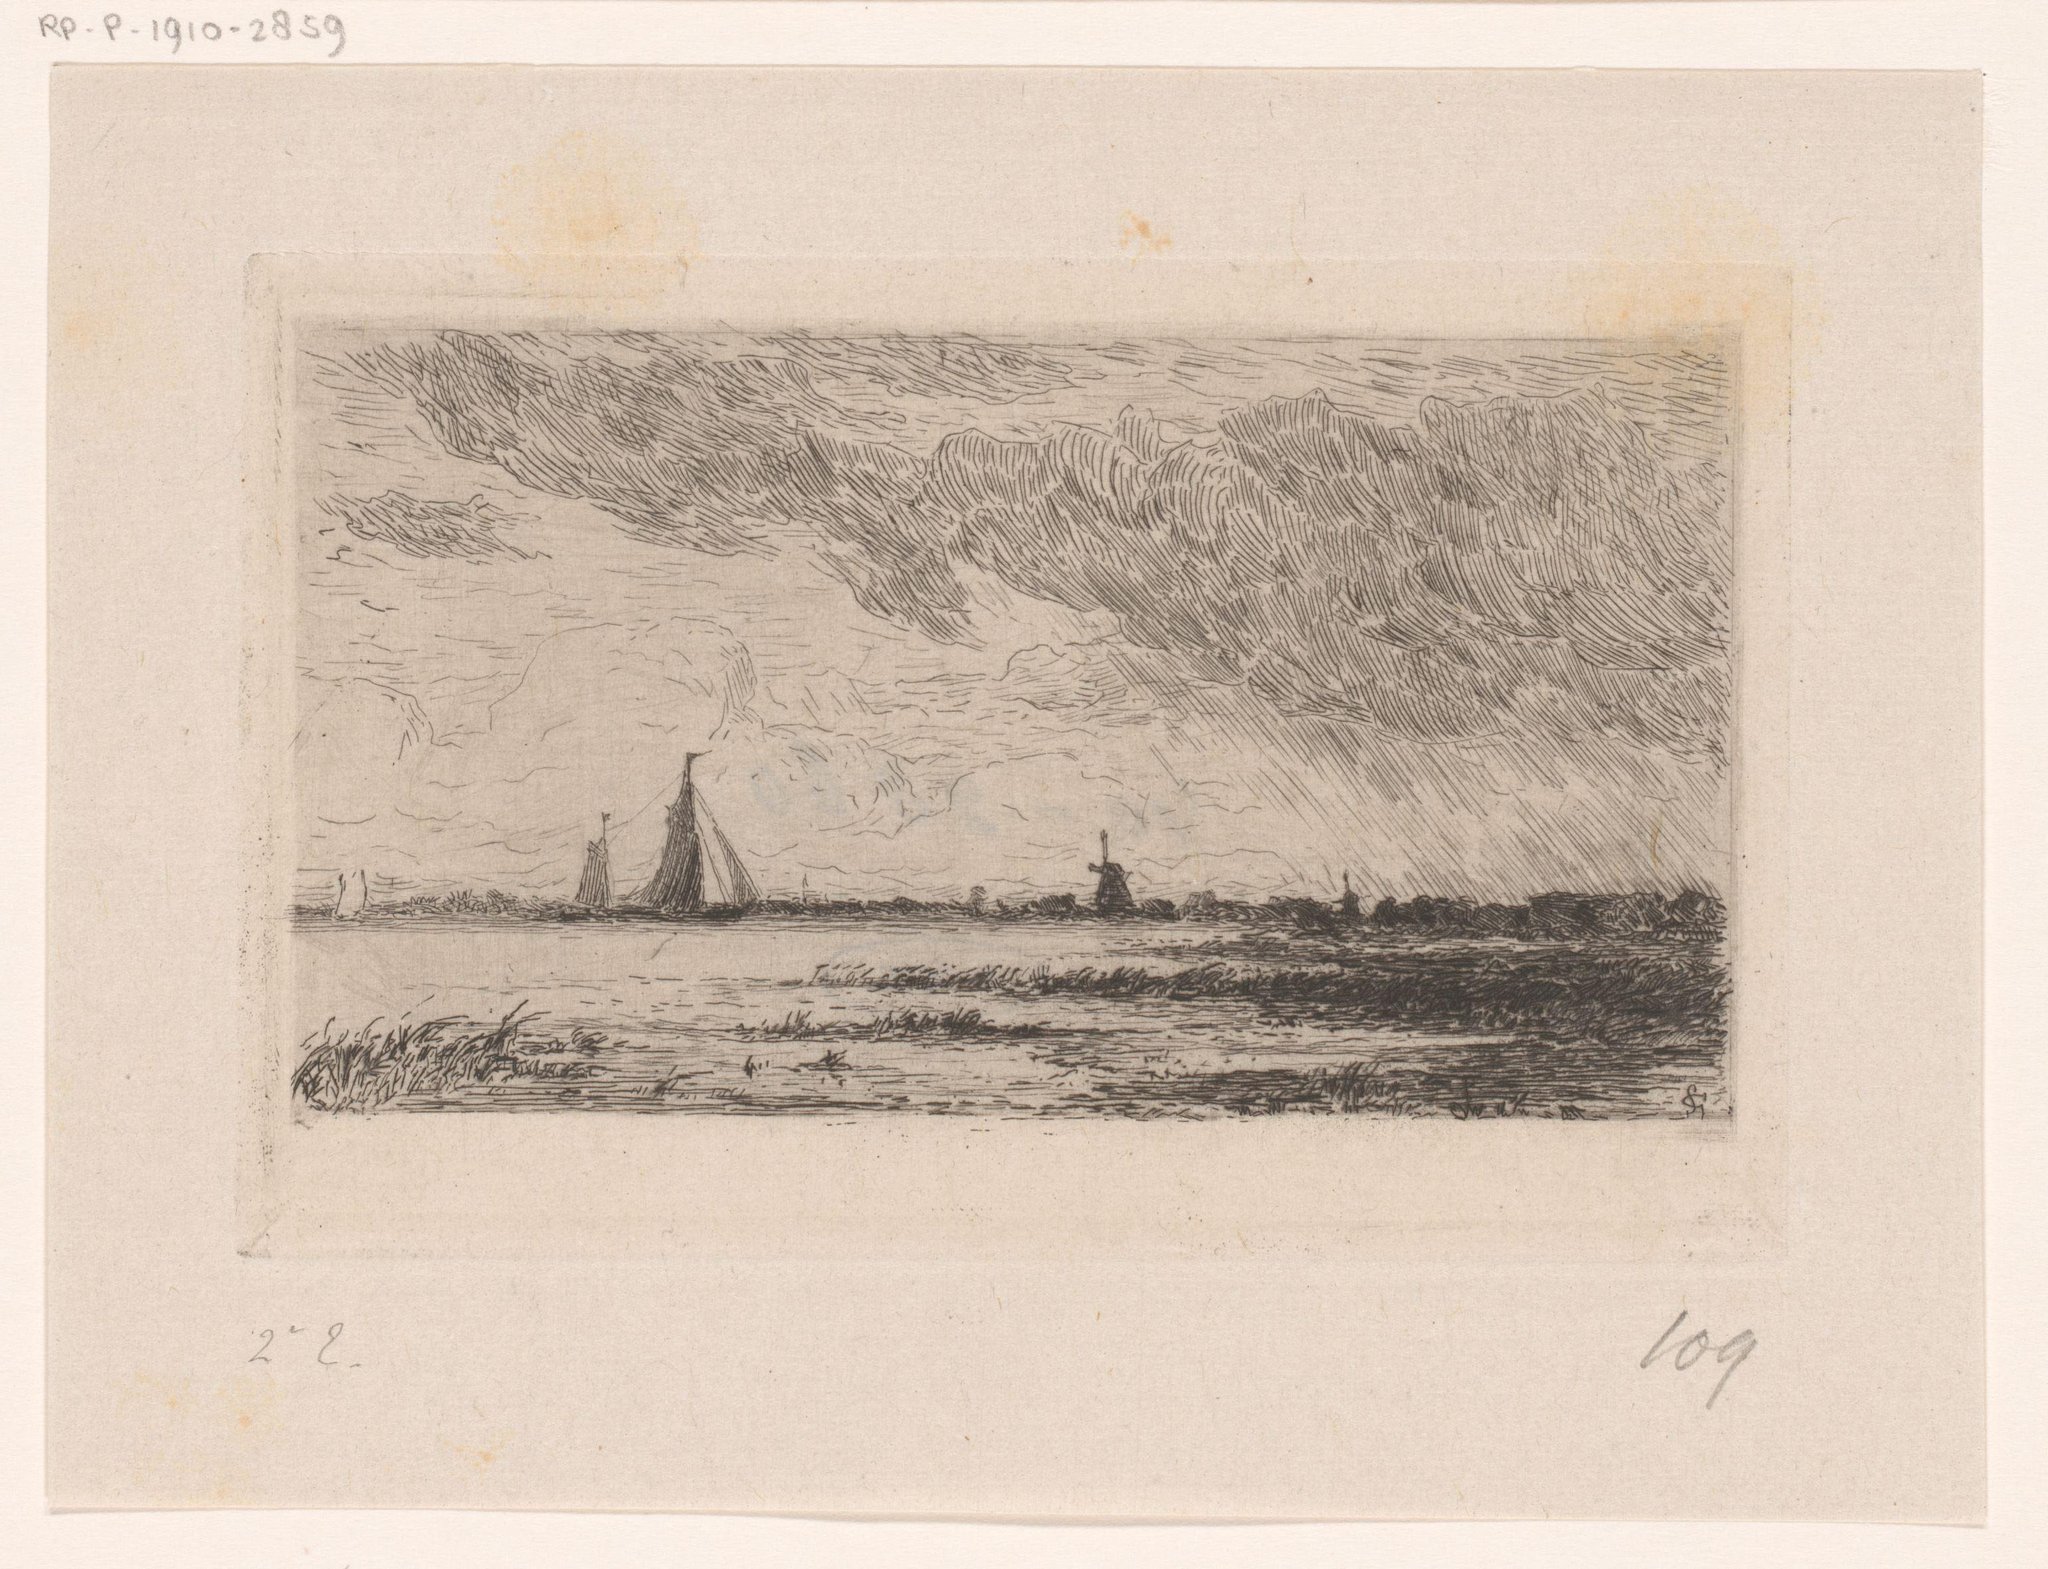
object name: print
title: Gezicht op de Biesbosch bij Dordrecht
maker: carel nicolaas storm van s-gravesande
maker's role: draughtsman, print maker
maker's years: 1841-1924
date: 1880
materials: paper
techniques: etching, intaglio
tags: windmill in landscape, pond, pool, dordrecht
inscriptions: collector's mark: Lugt 2228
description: Links twee zeilschepen; aan de horizon twee molens.